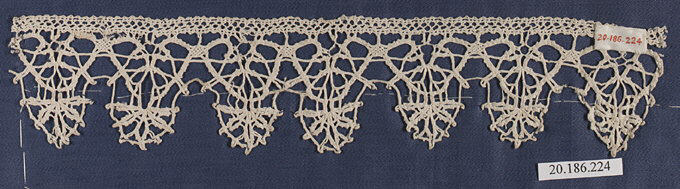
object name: edging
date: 1601-1700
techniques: lace